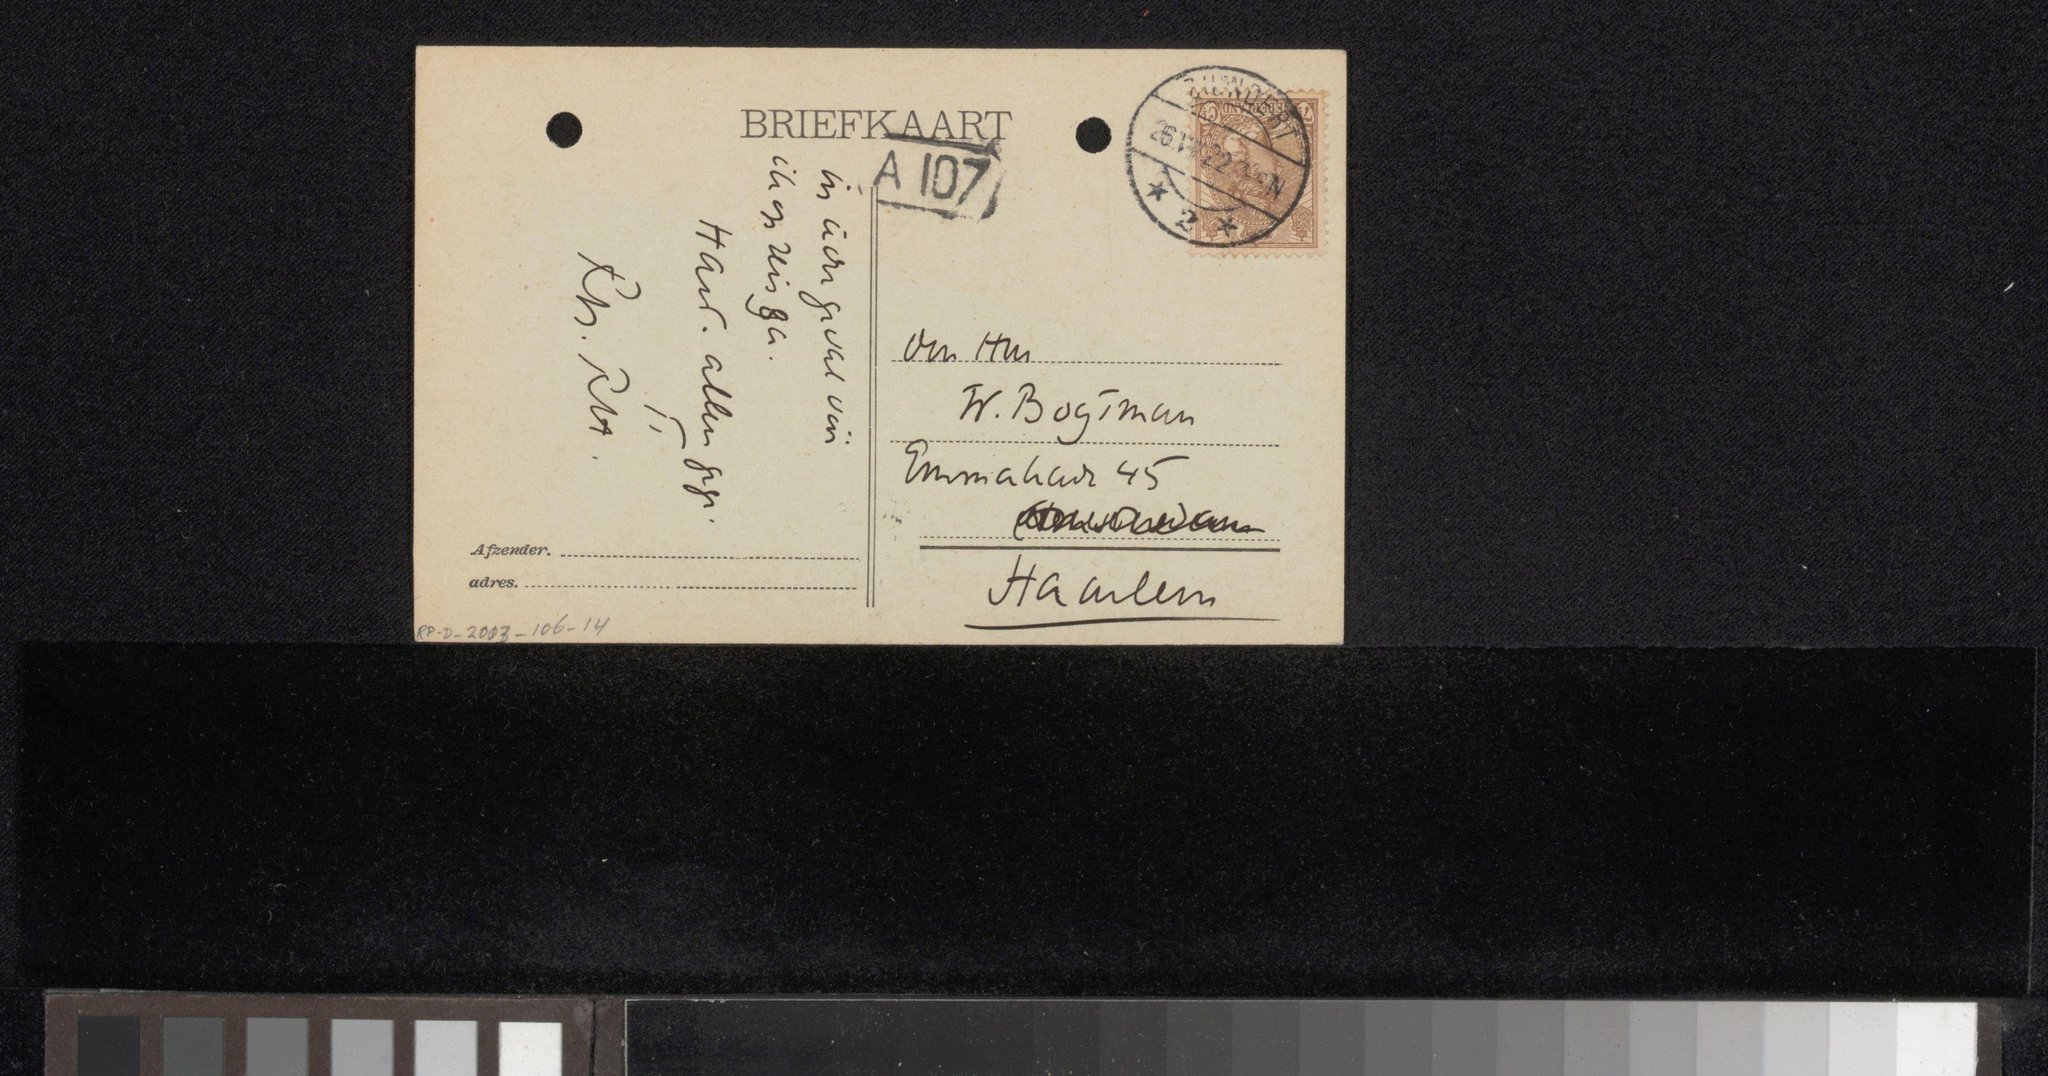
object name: postcard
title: Briefkaart aan Willem Bogtman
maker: richard nicolaüs roland holst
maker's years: 1868-1938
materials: cardboard, ink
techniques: pen, writing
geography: zundert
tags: haarlem, willem bogtman, applied arts, arts and crafts; industrial design, exhibition ~ art